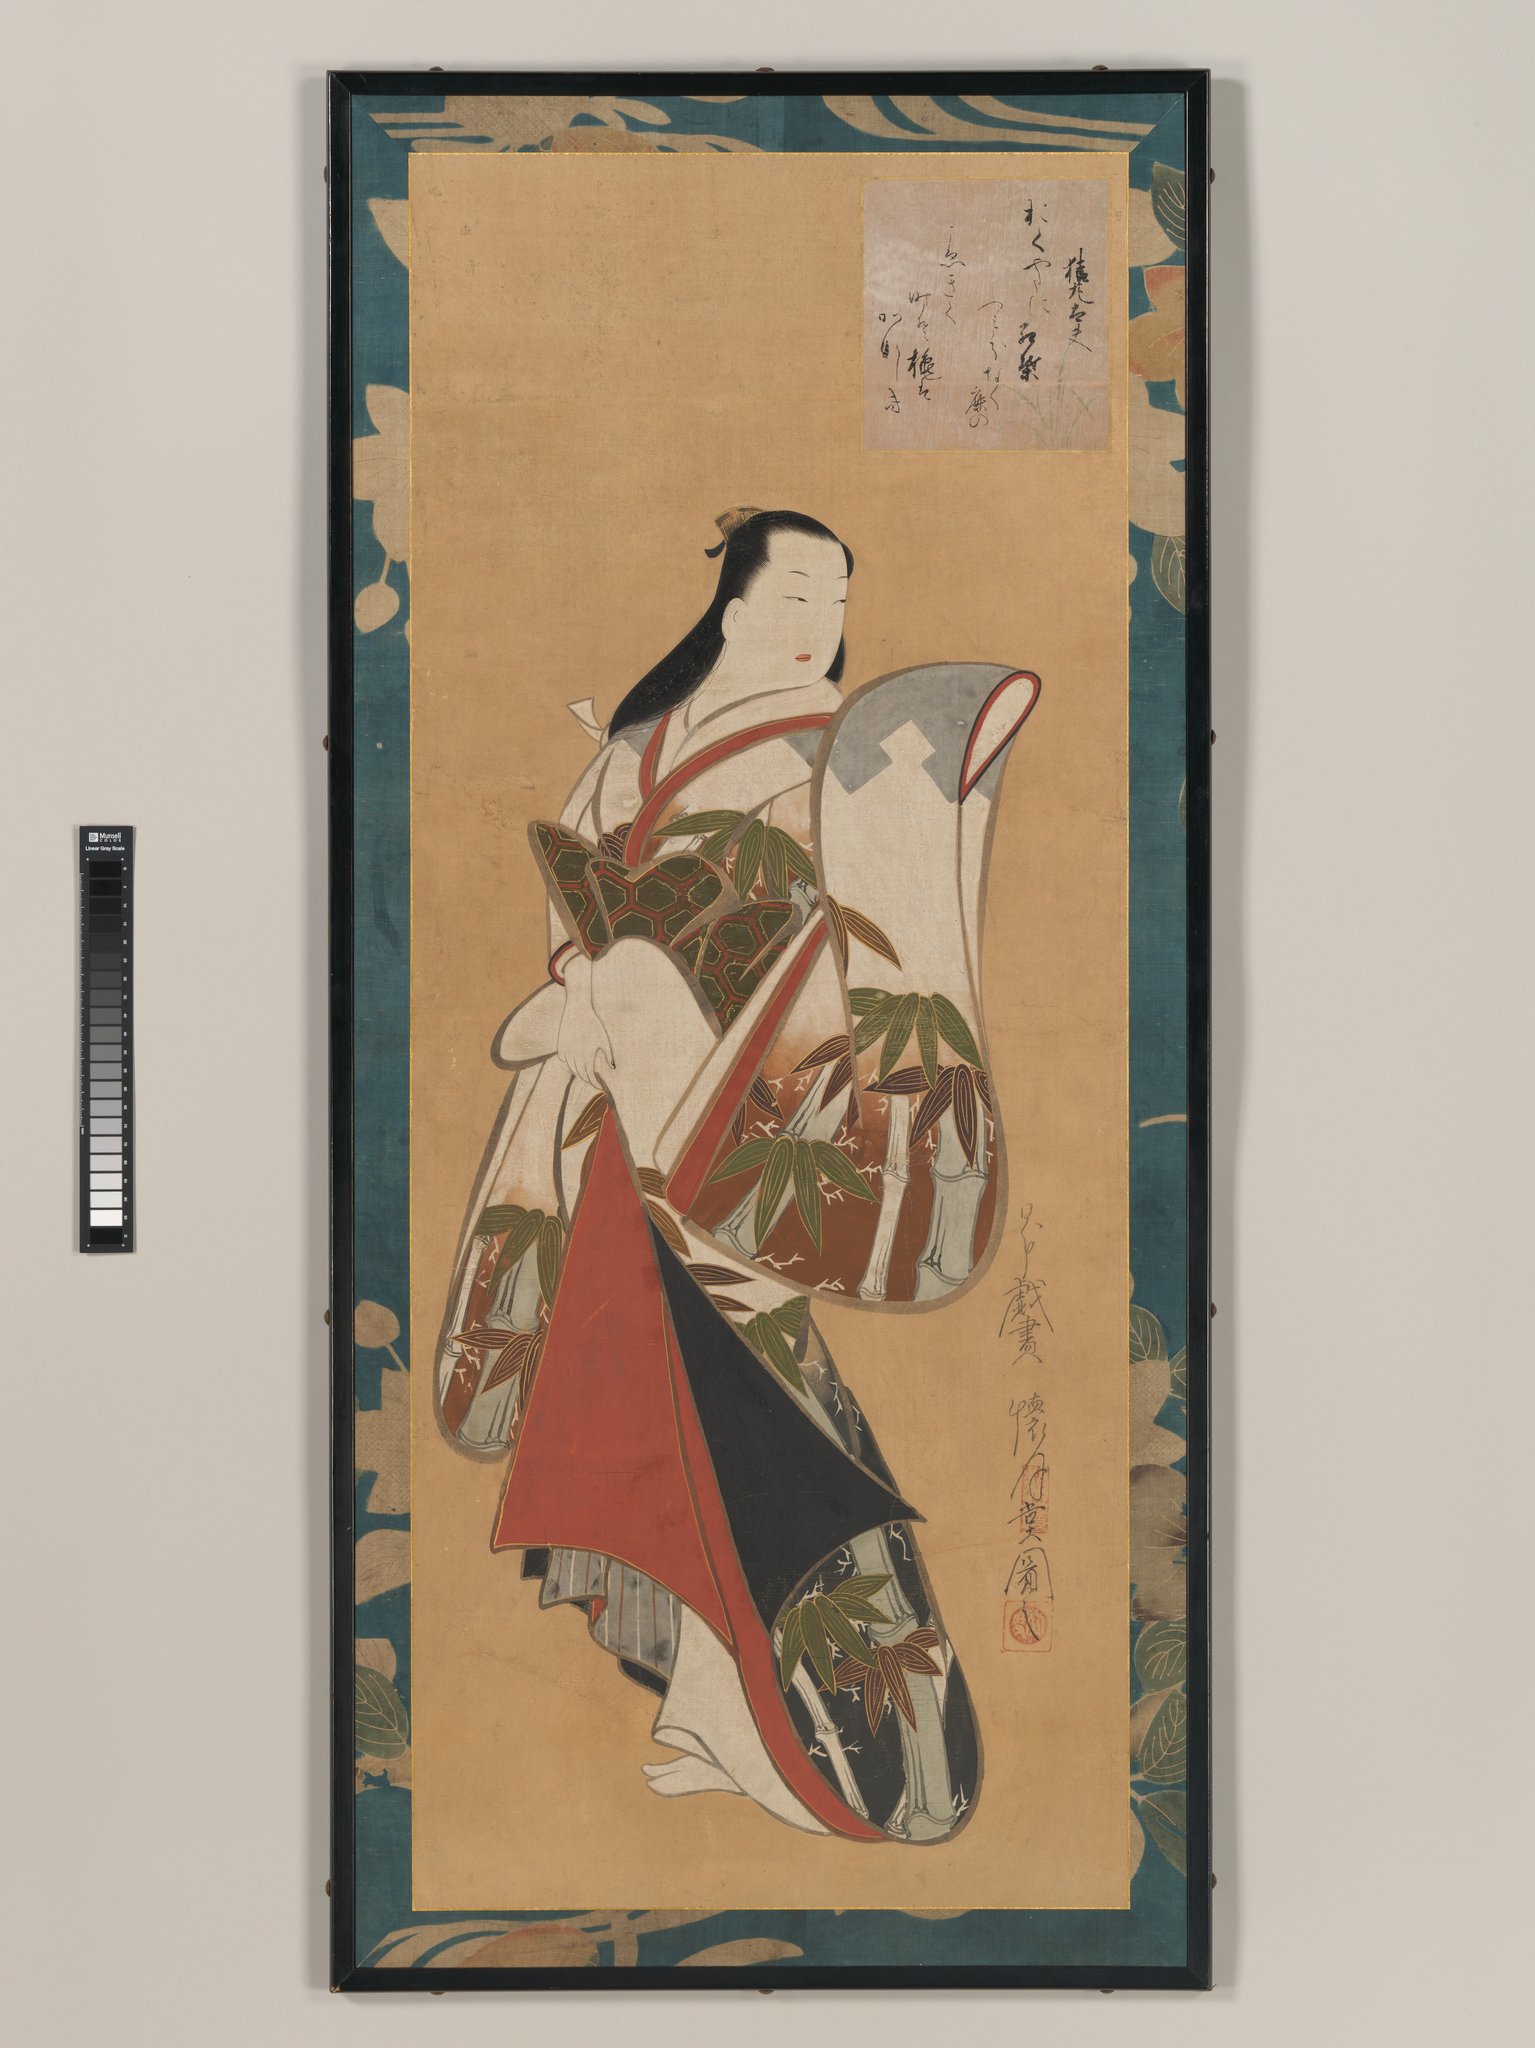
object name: painting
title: Standing Courtesan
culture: japanese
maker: kaigetsudō ando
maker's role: artist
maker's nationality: japanese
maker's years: 1671-1743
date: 1701-1733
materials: ink, panel, paper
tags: women